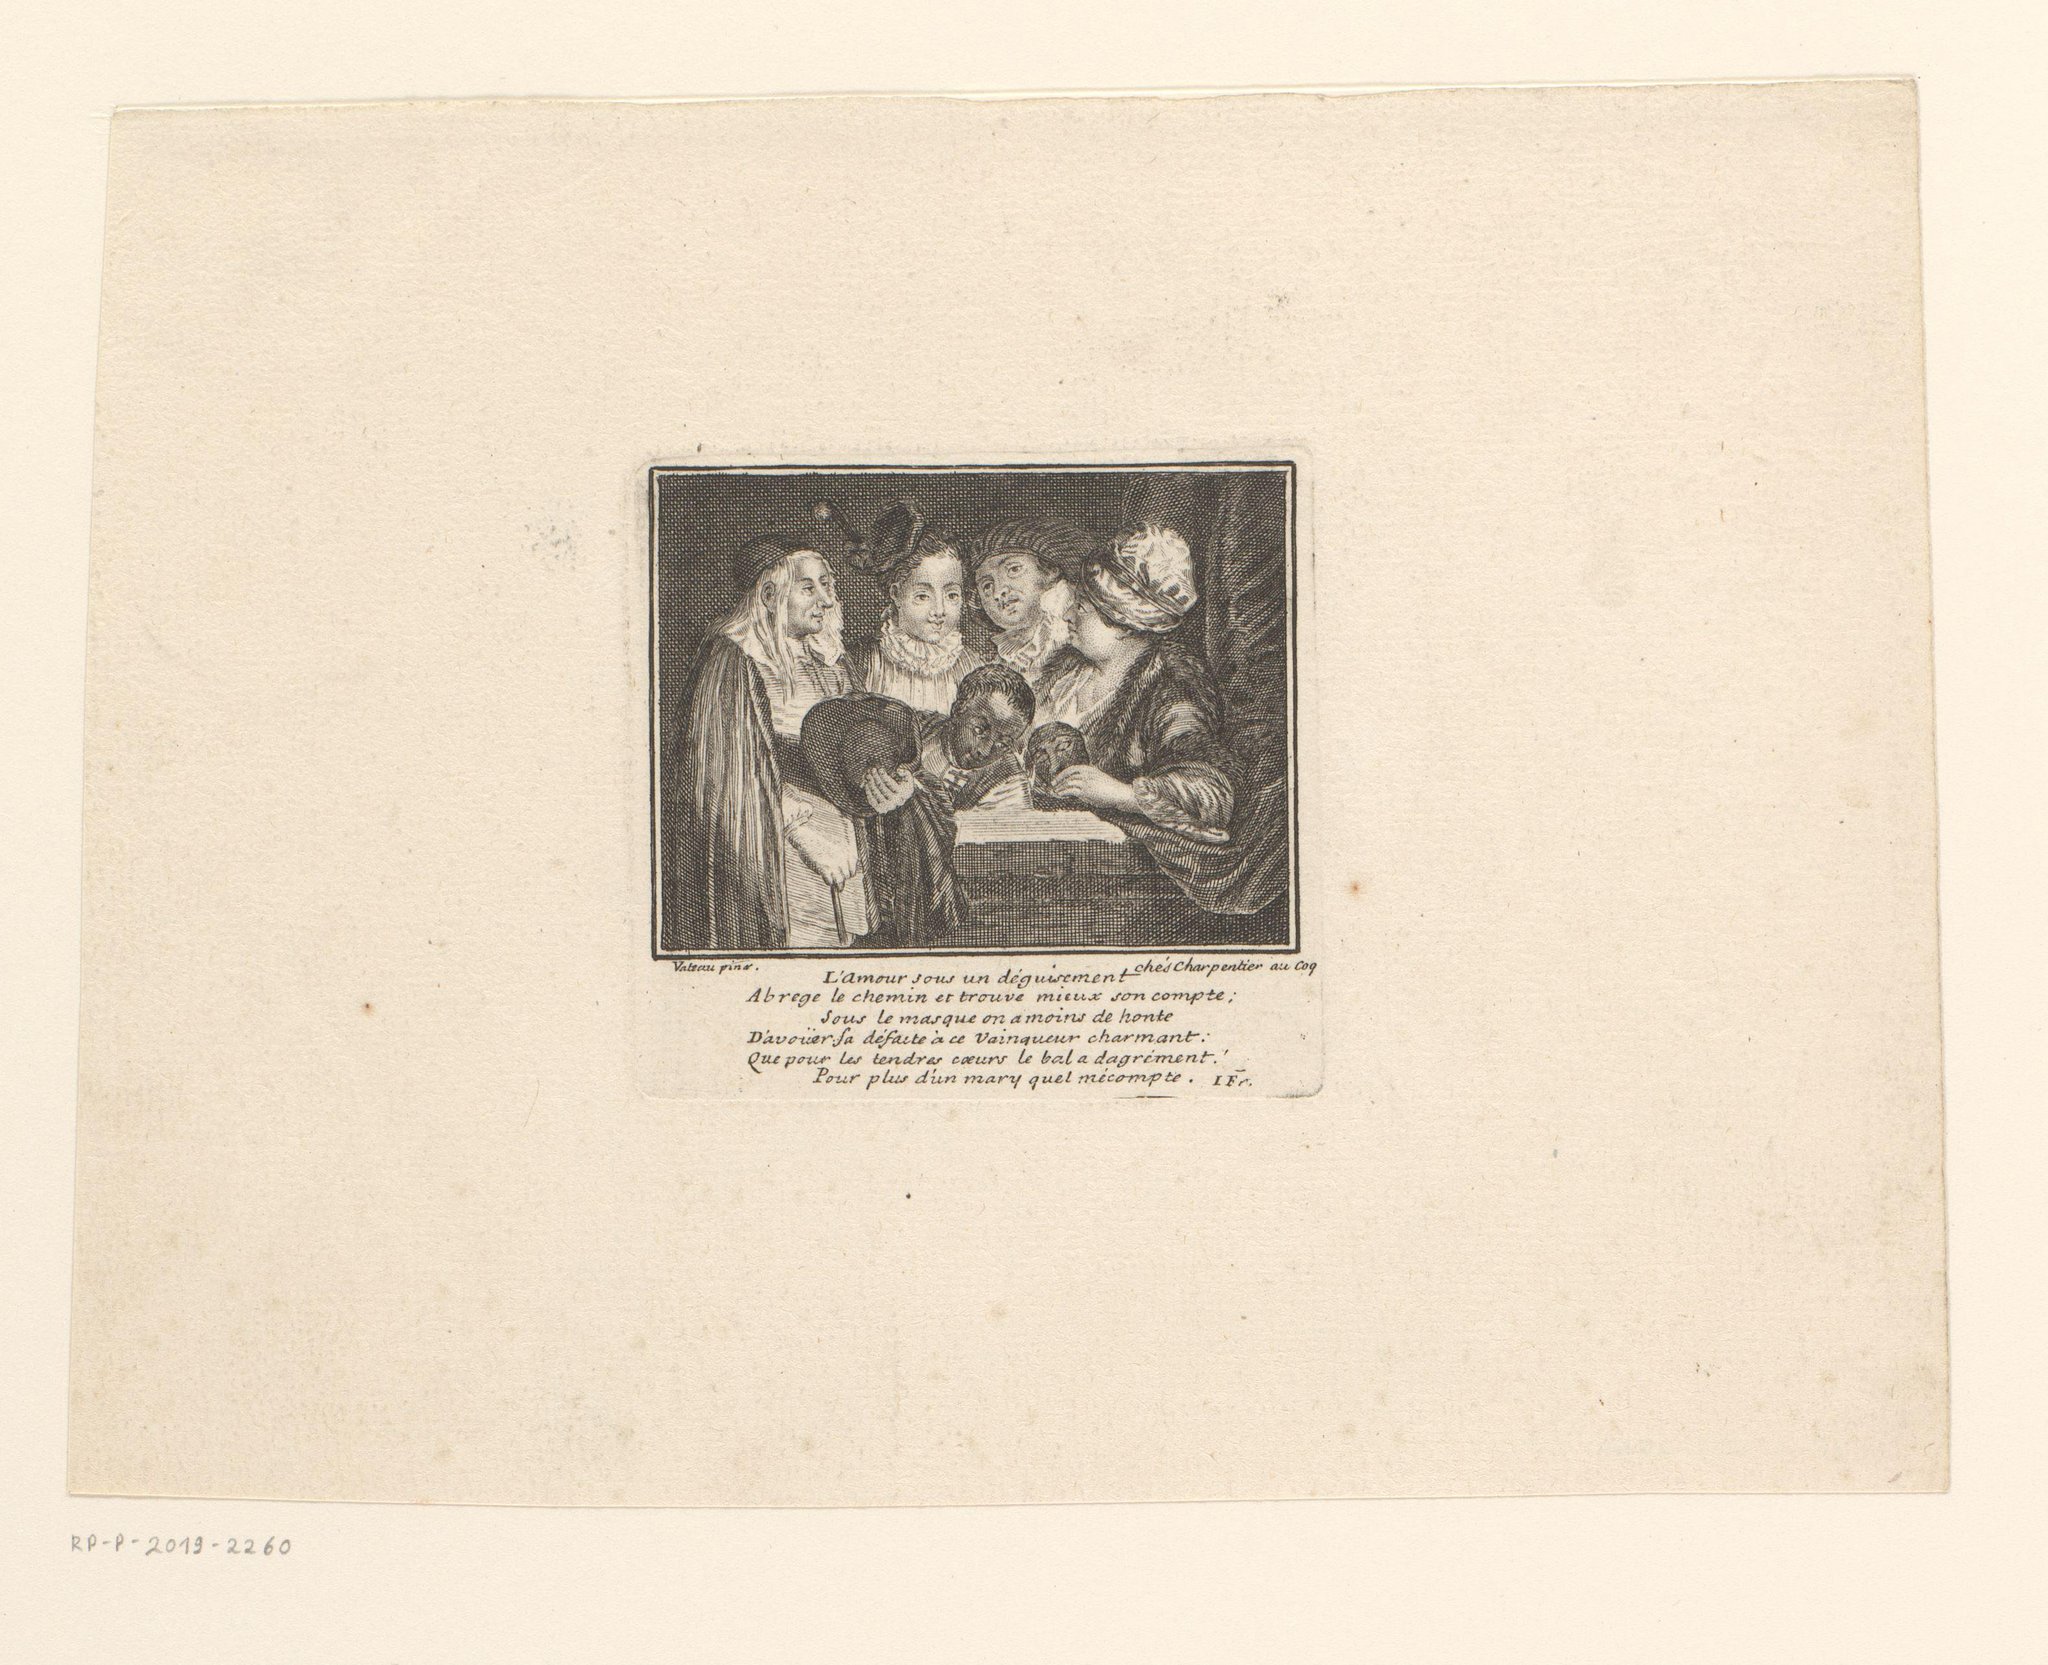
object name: print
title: Vijf acteurs uit de Comédie-Francaise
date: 1712-1750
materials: paper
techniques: etching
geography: france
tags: group of actors, troupe; actors on the stage, comedy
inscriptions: collector's mark: Lugt 2233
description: Het schilderij van Watteau bevindt zich in het Hermitage Museum in Sint-Petersburg (inventarisnummer 1131).